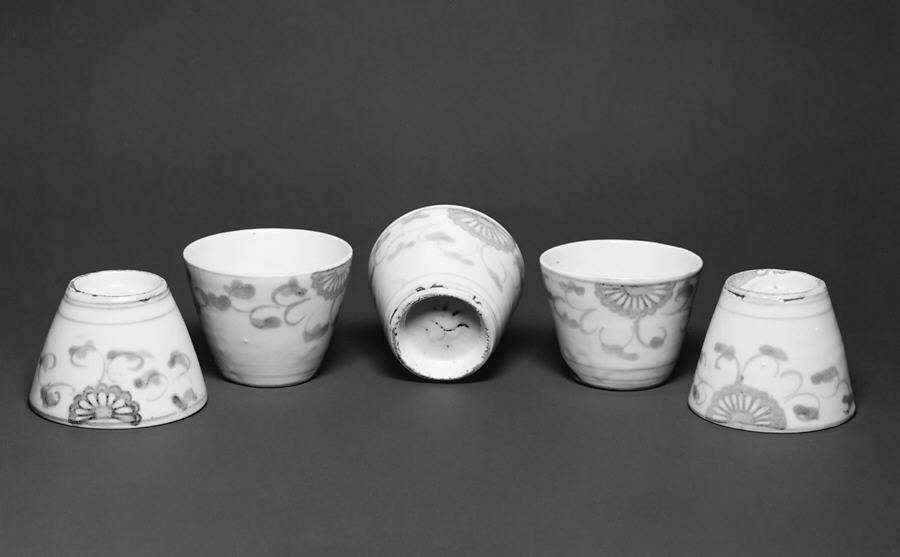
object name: soba cup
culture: japanese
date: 1801-1900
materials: cobalt, porcelain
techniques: painting, underglaze